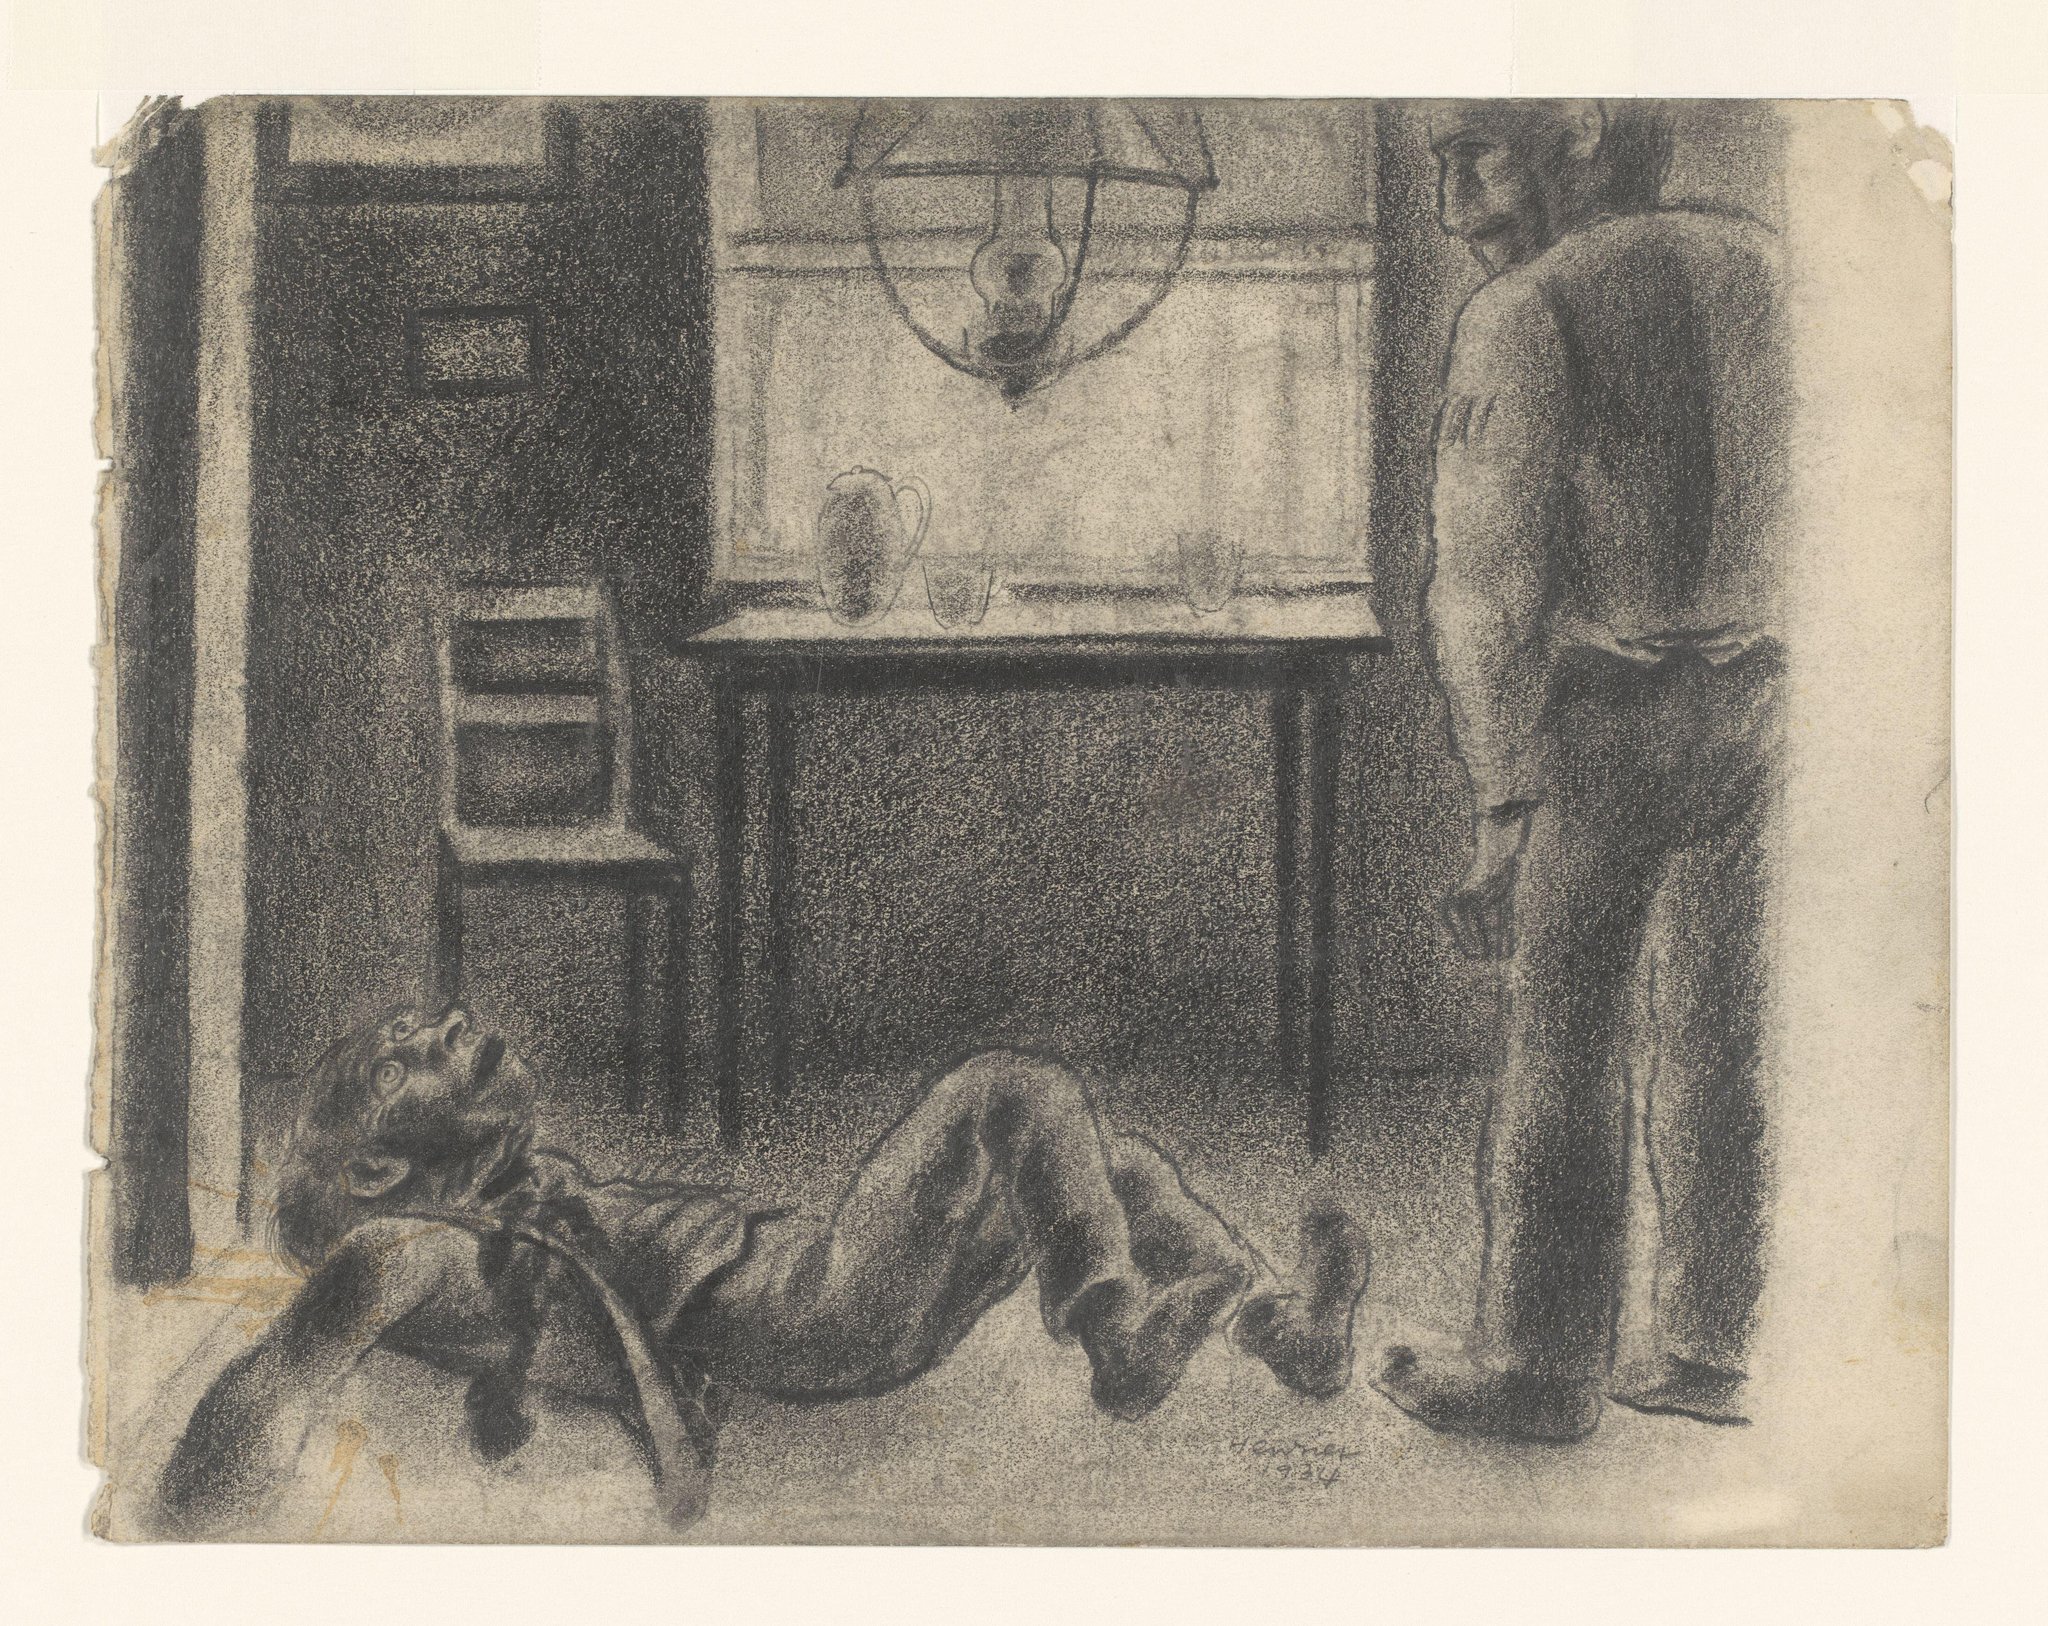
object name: drawing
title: Interieurscène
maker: henk henriët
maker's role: draughtsman, print maker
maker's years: 1903-1945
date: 1934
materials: paper, pencil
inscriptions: signature and date: ‘Henriet 1934’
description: De huidige titel is door het Rijksmuseum overgenomen van het Instituut Collectie Nederland.